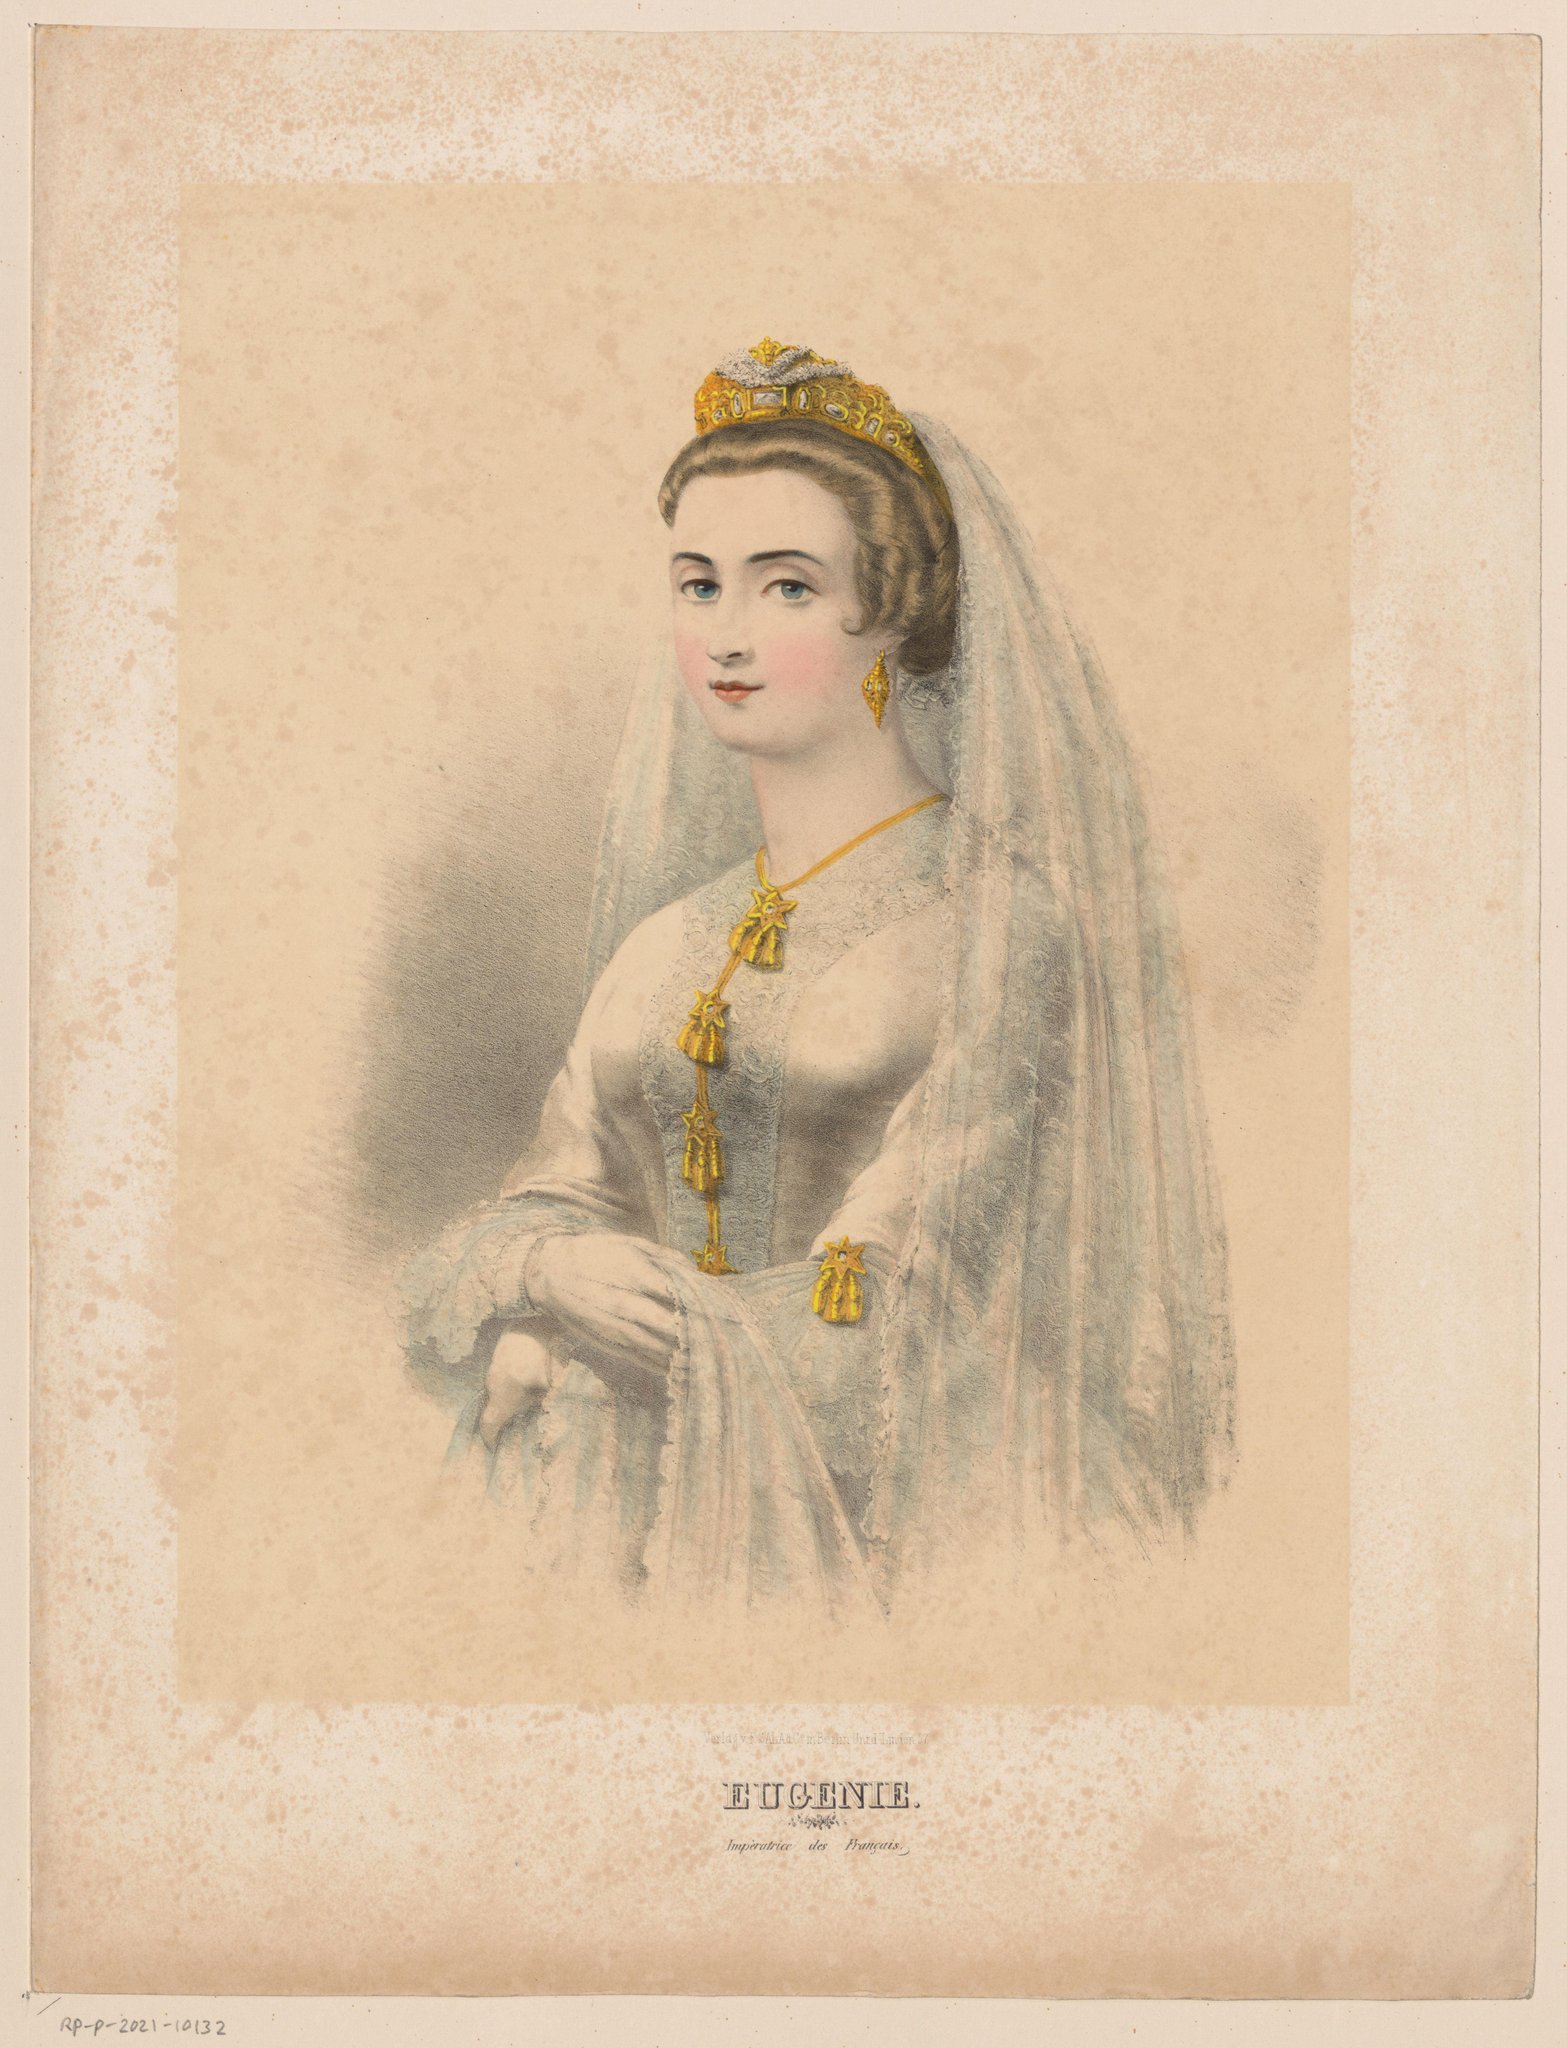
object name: print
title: Portret van Eugénie de Montijo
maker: Anonymous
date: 1853-1871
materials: paper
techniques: hand coloring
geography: germany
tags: sevilla, historical persons - bb - woman, queen, empress, etc. (wife of a ruler)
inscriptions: check stamp: ‘F. Sala & Co. Kunst-verlag Berlin’